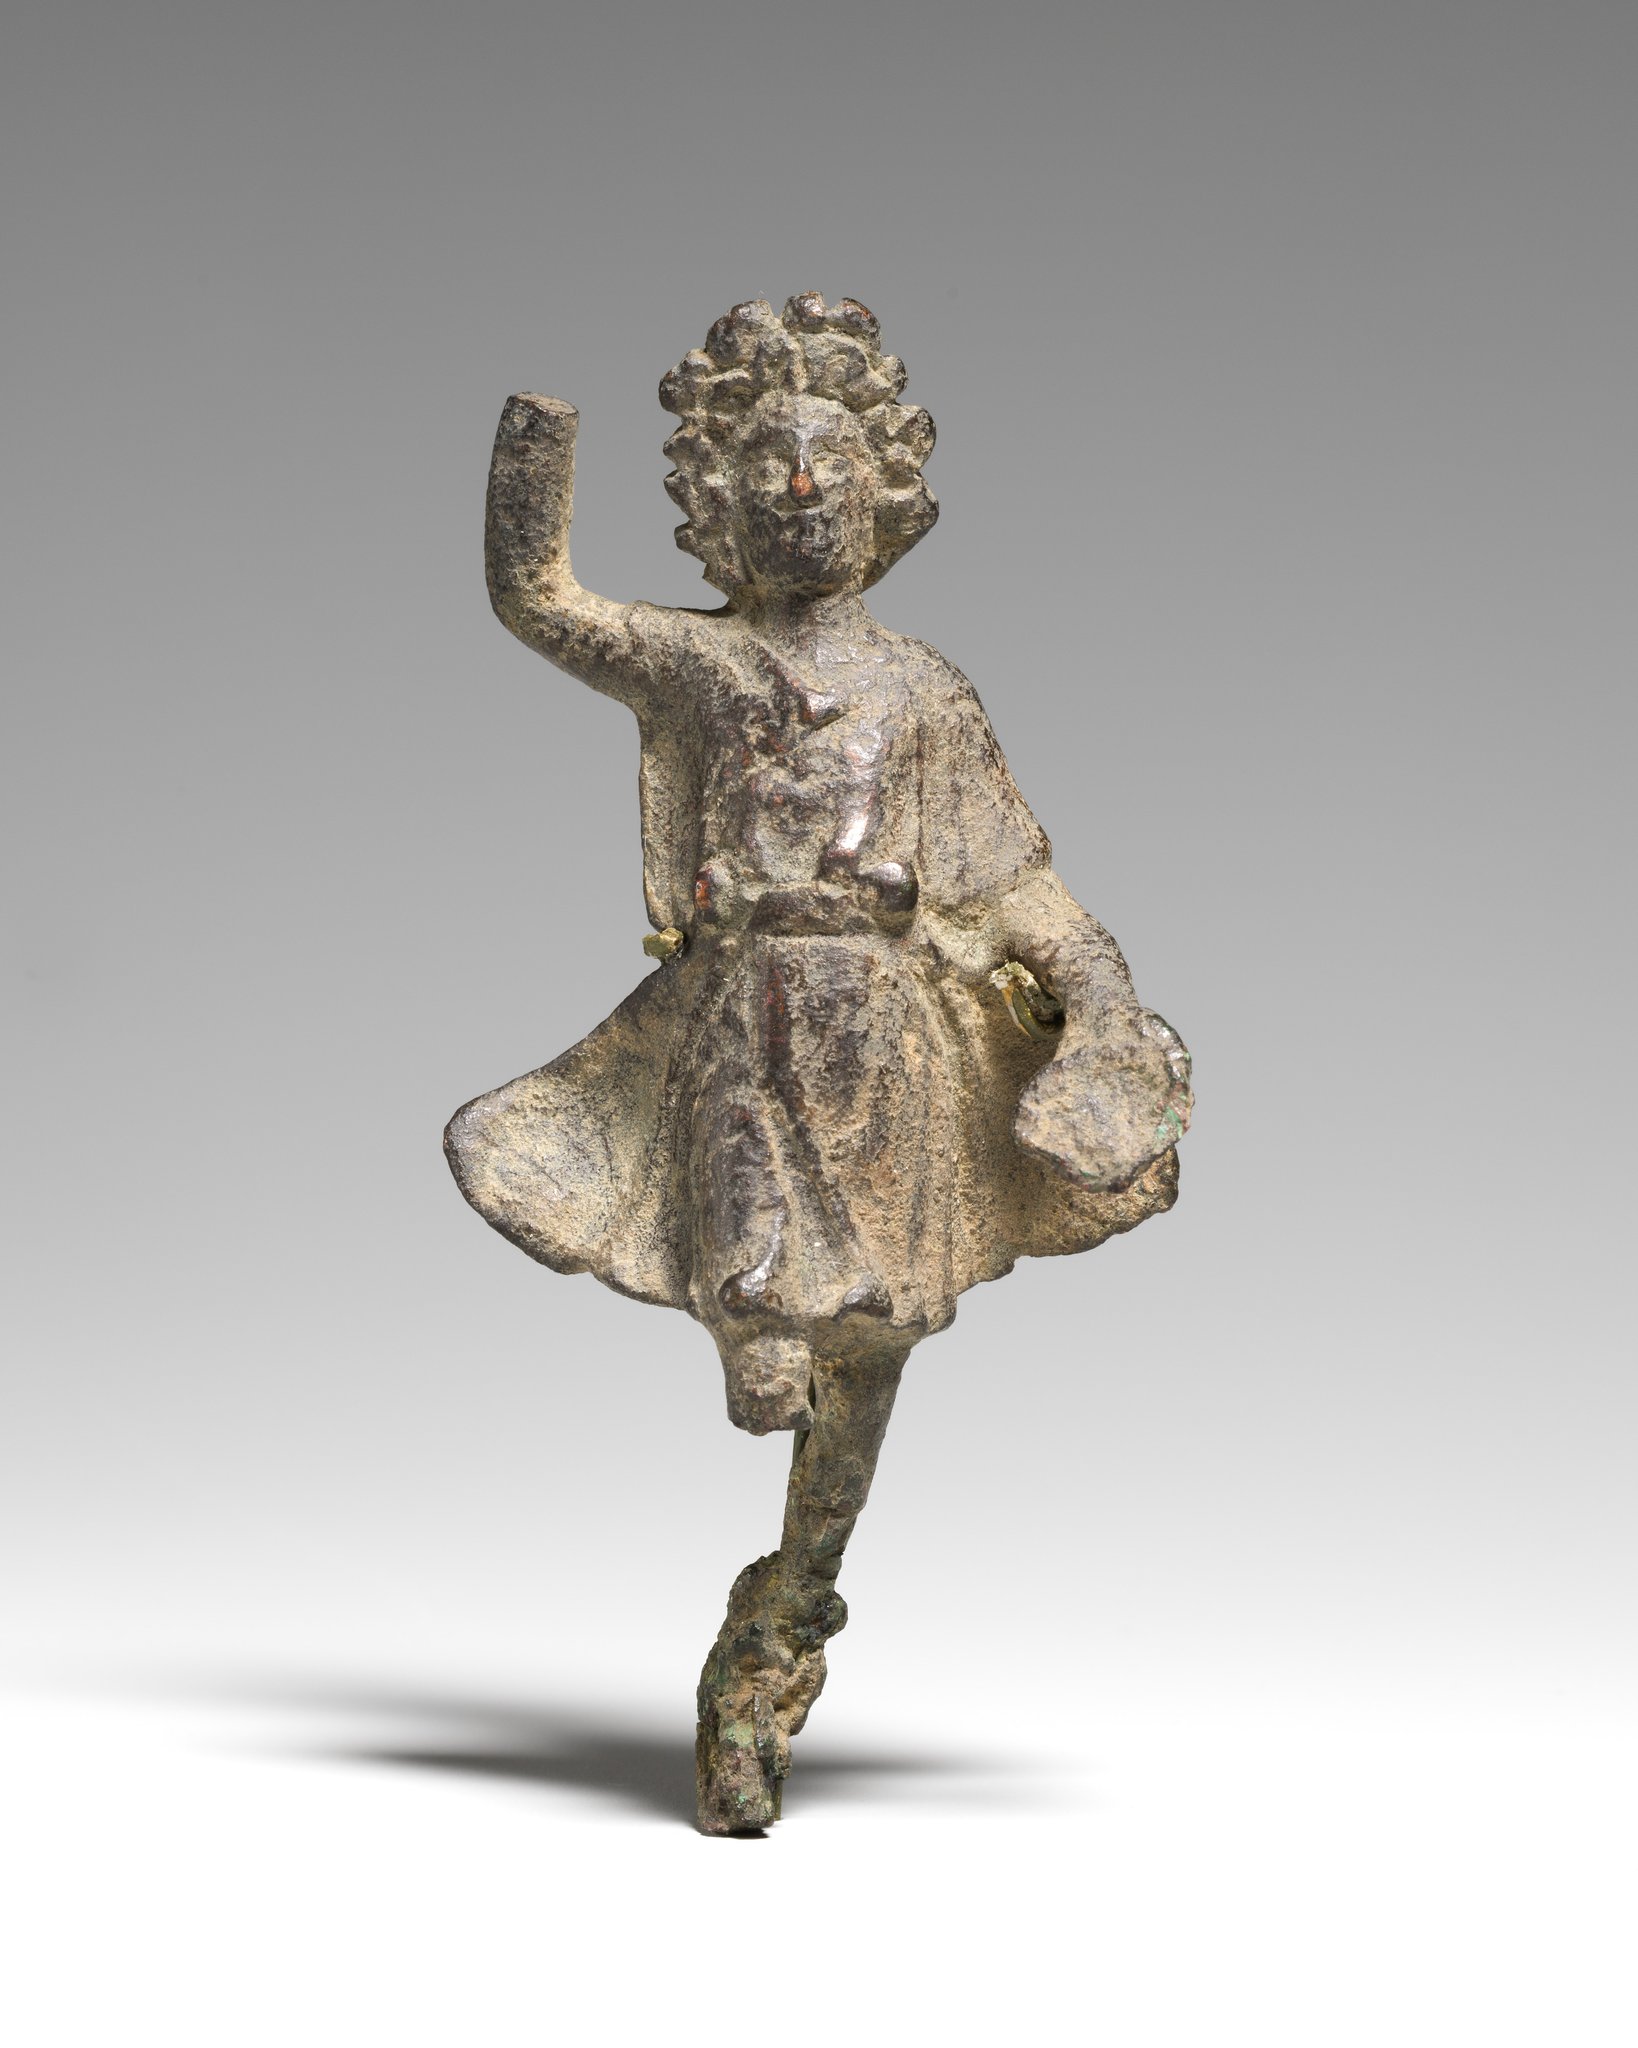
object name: statuette of a lar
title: Bronze statuette of a Lar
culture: roman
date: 1-200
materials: bronze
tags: men